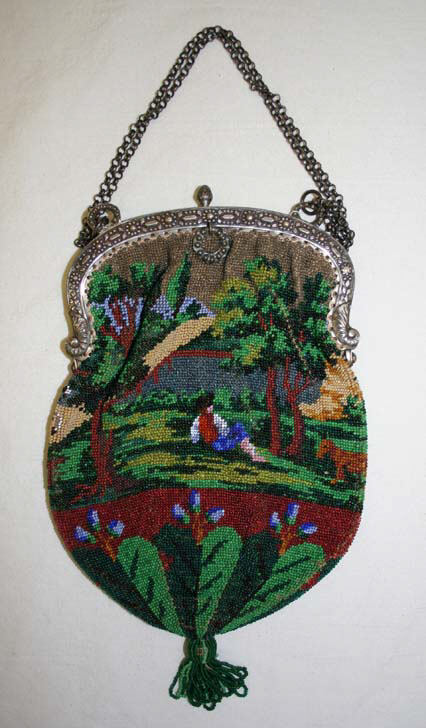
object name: bag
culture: french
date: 1834-1866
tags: boys,horses,carriages